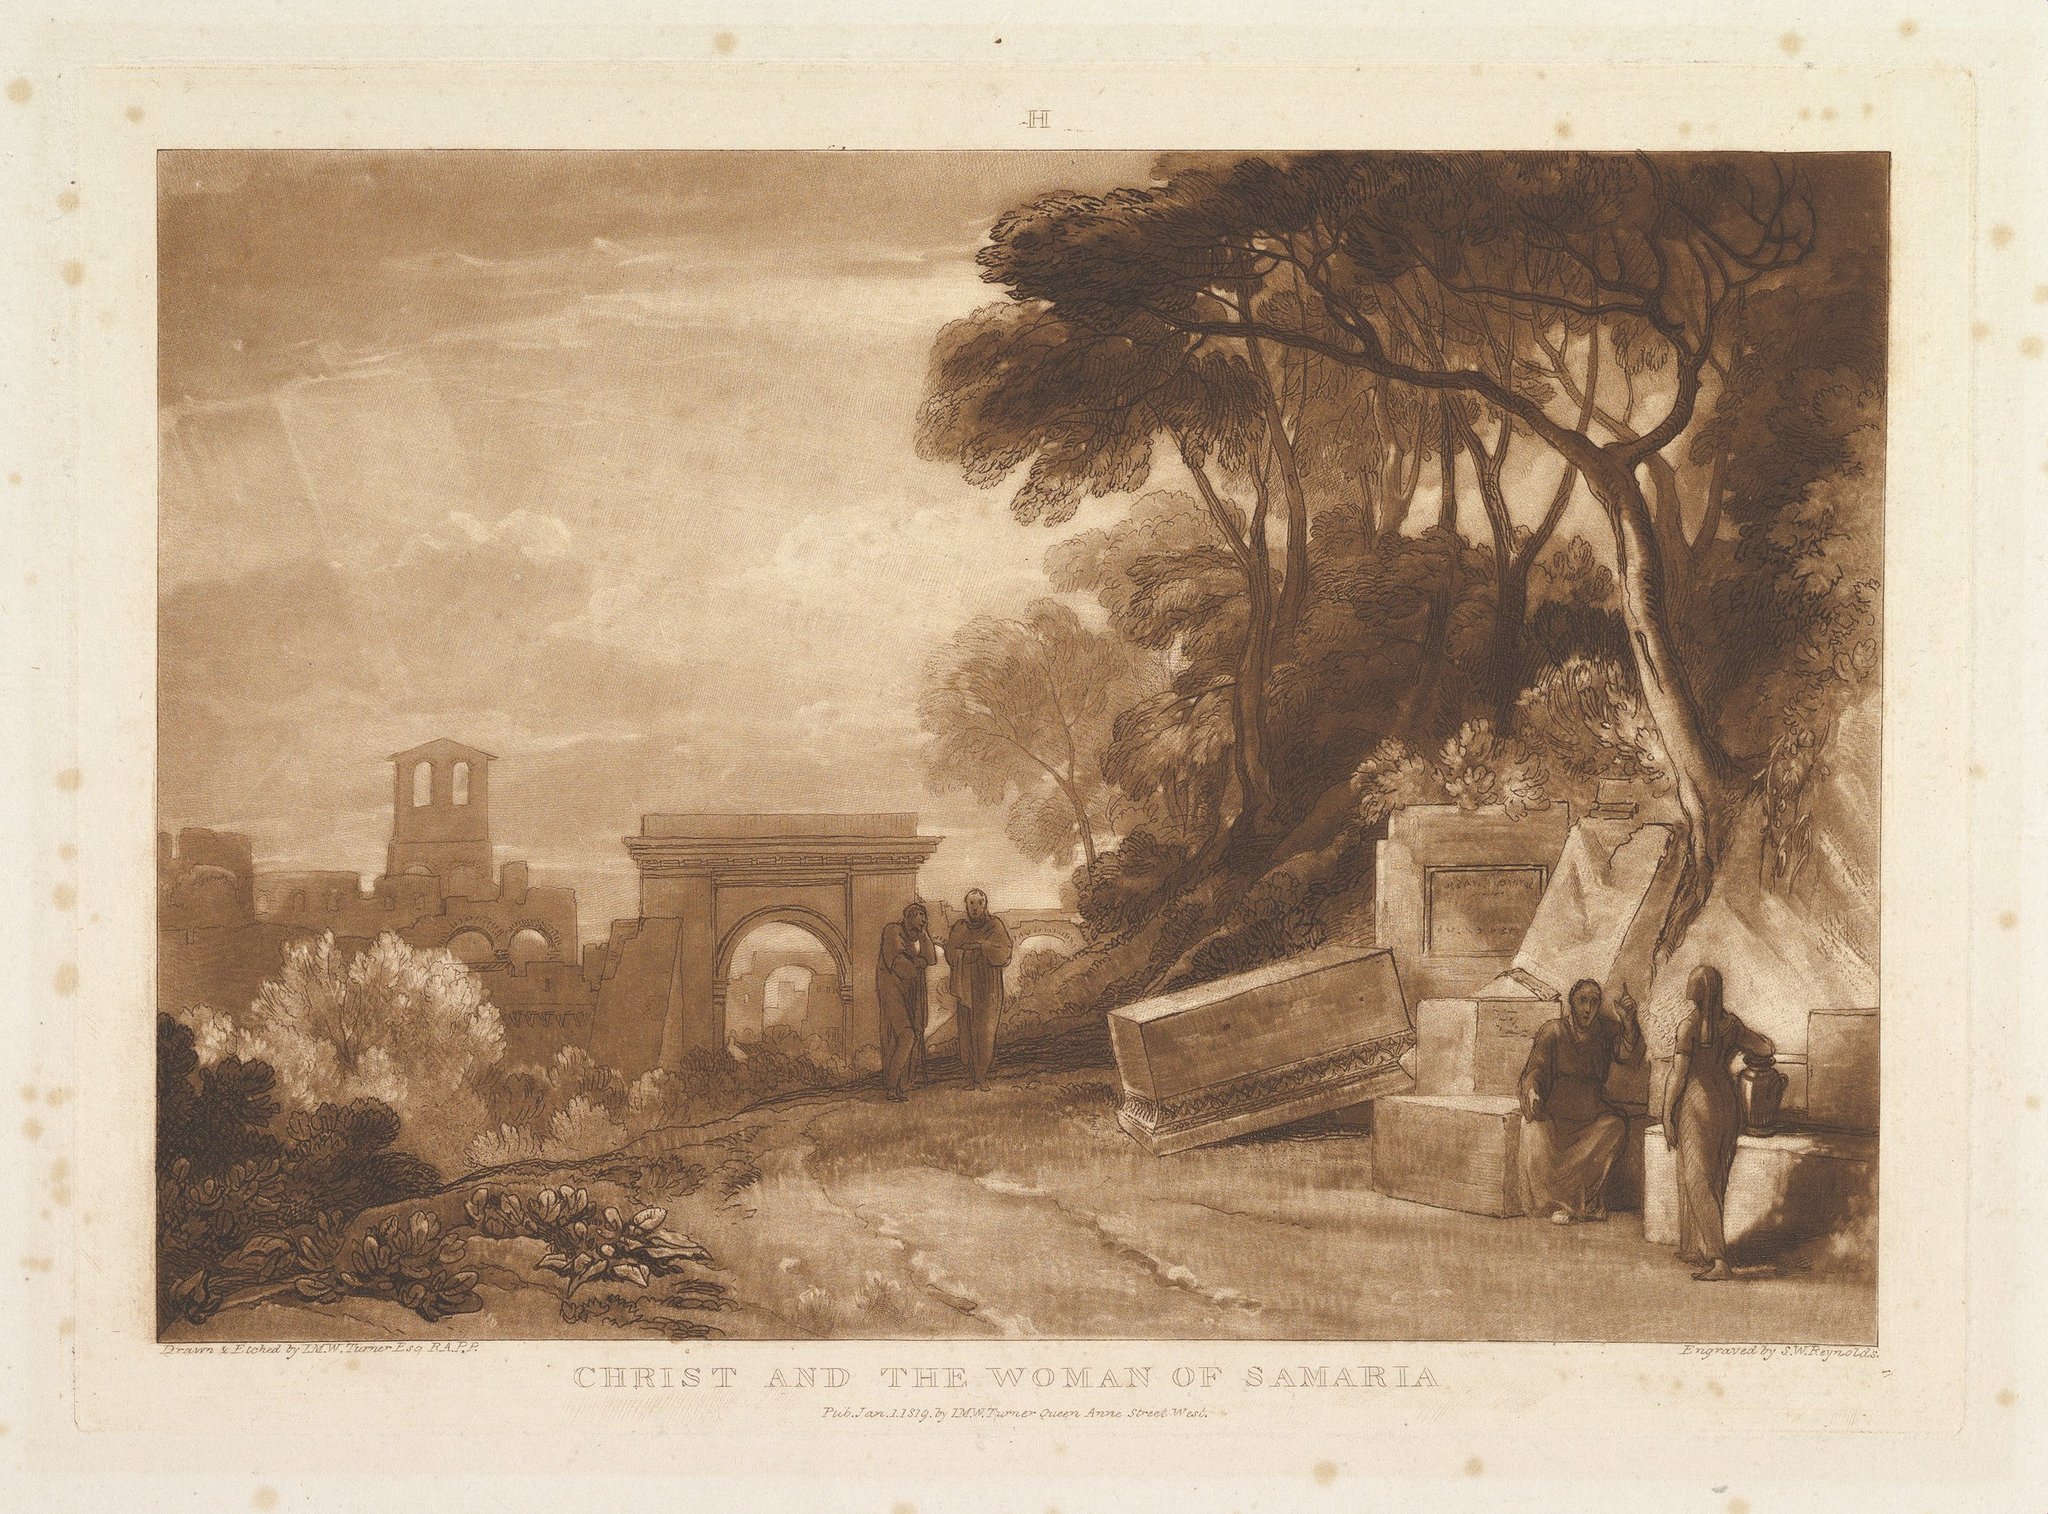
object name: print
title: Christ and the Woman of Samaria, part XIV, plate 71 from "Liber Studiorum"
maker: joseph mallord william turner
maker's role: artist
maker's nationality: british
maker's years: 1775-1851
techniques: etching, mezzotint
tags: roads,women,trees,jesus